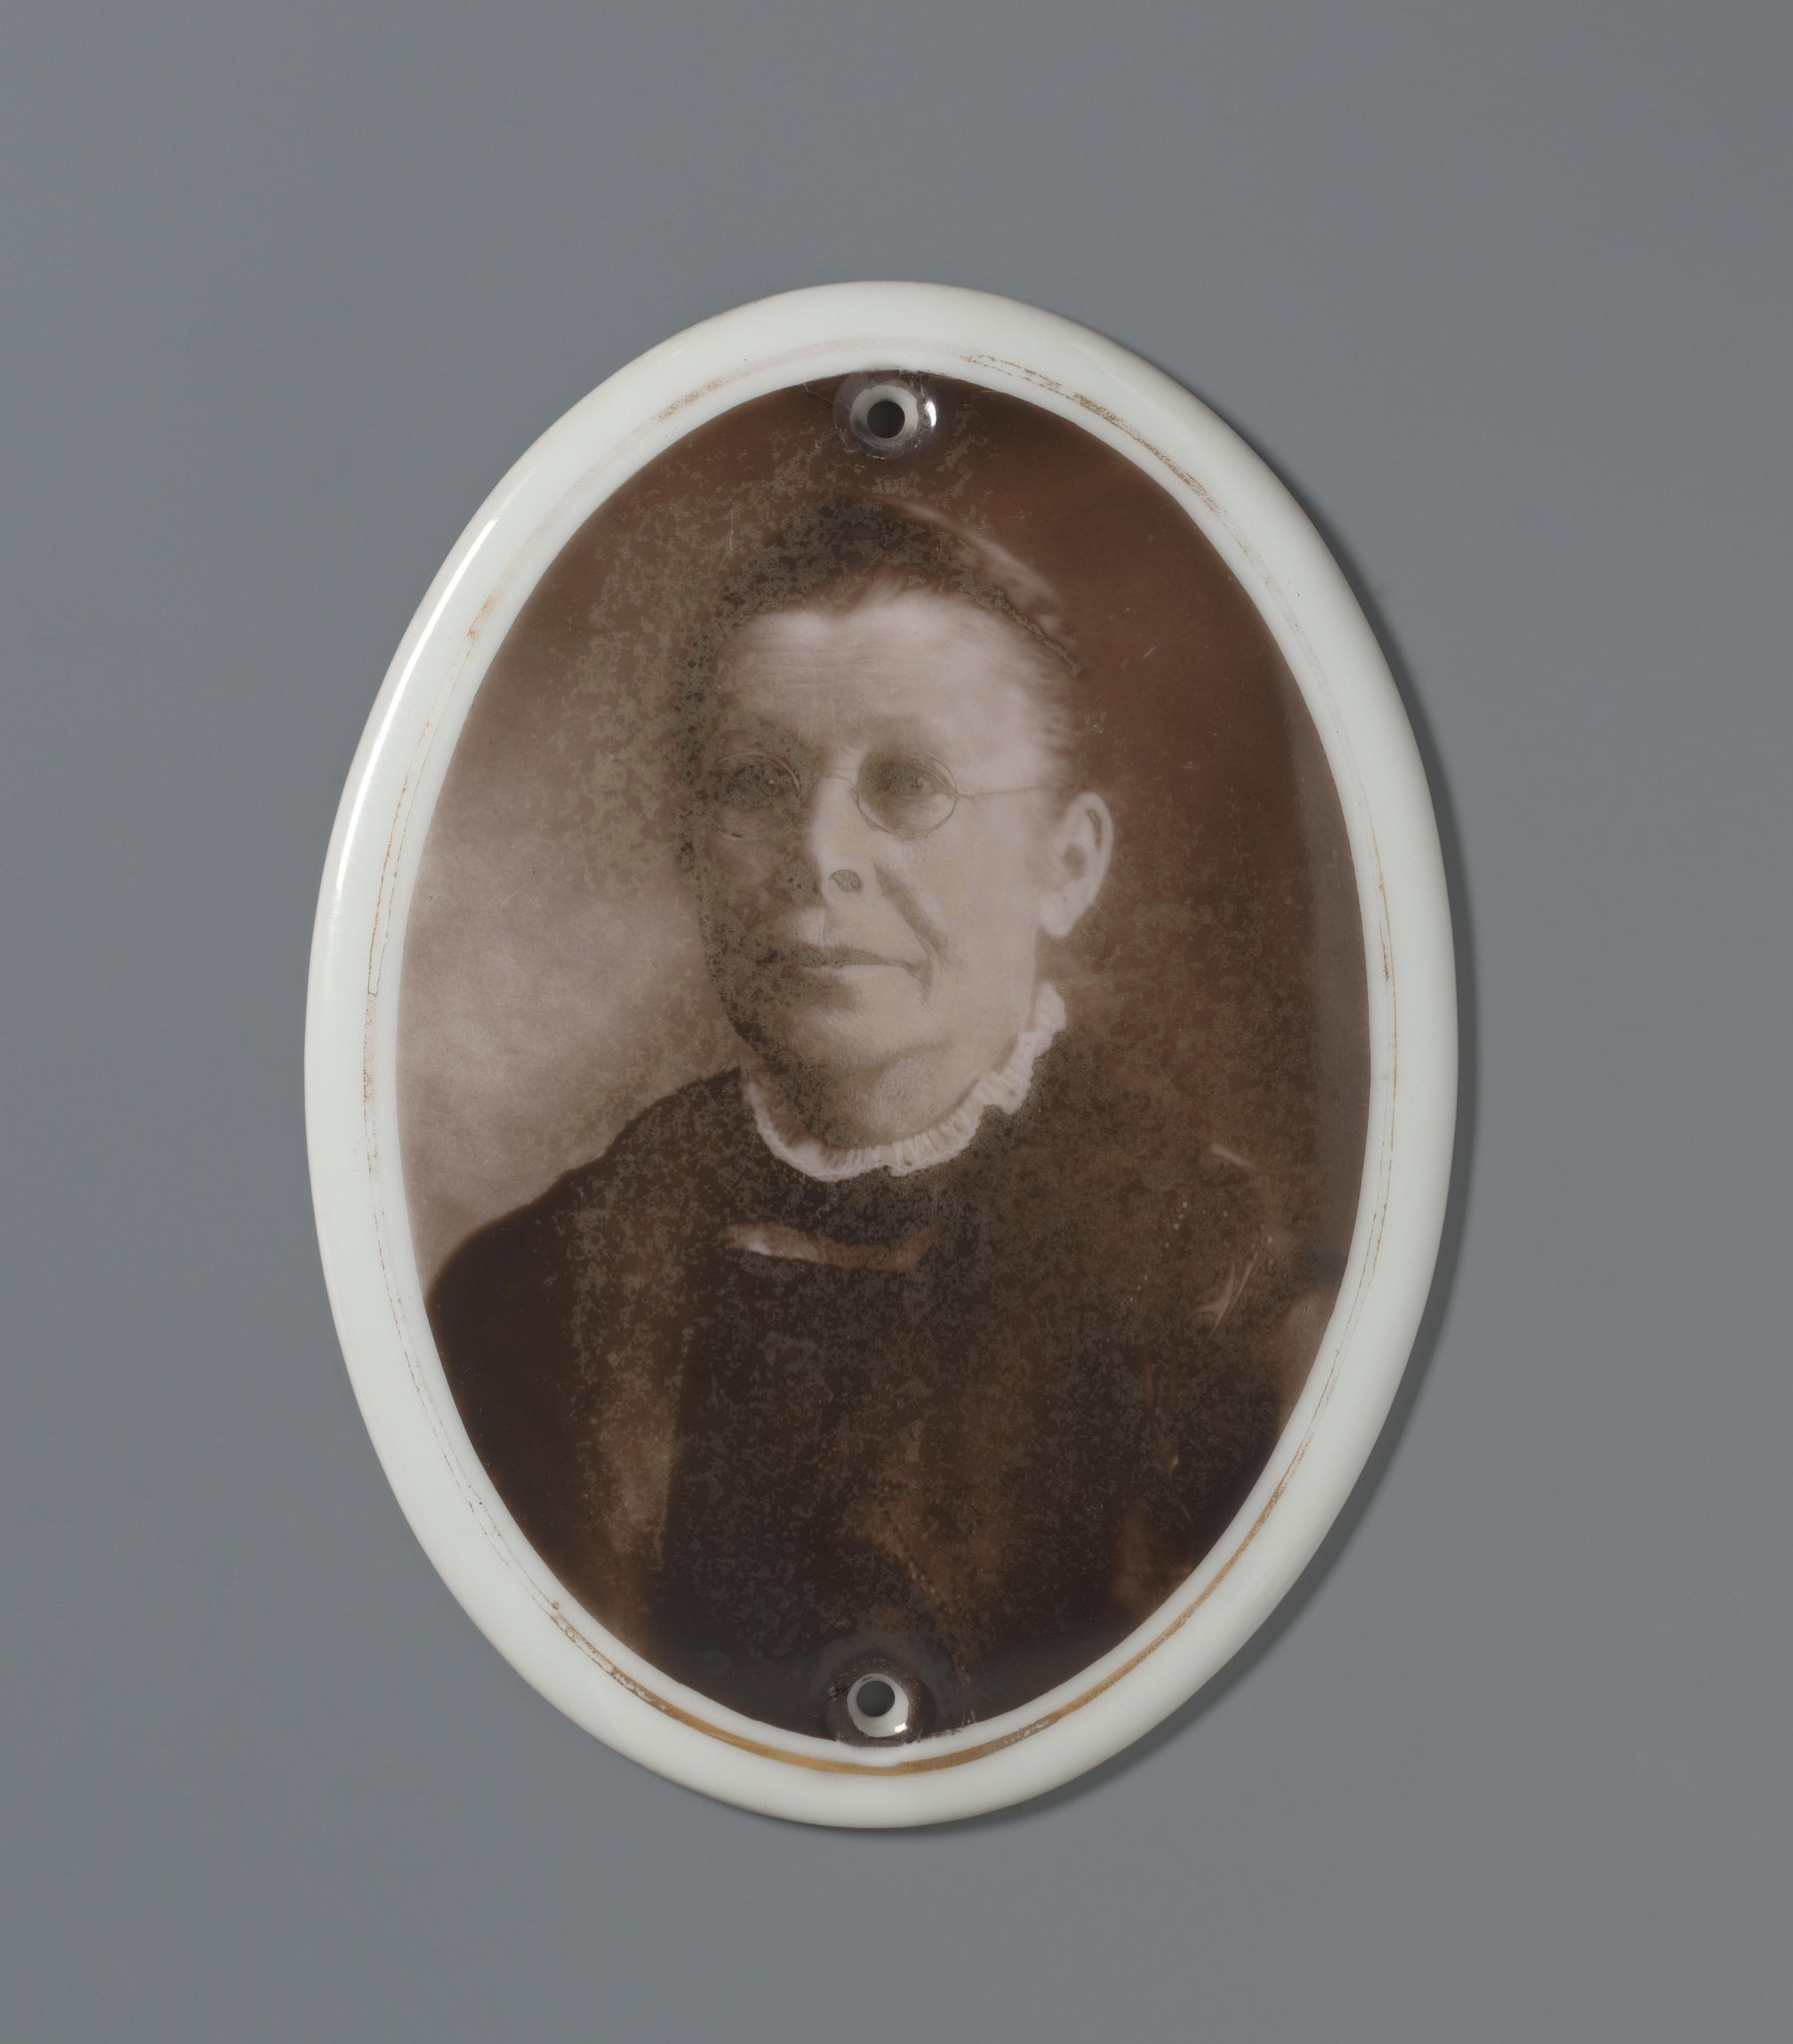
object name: photograph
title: Grafportret van een onbekende vrouw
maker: Anonymous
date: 1935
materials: ceramic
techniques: photoceramics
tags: anonymous historical person portrayed - bb - woman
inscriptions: number: ‘2e KL 4030’